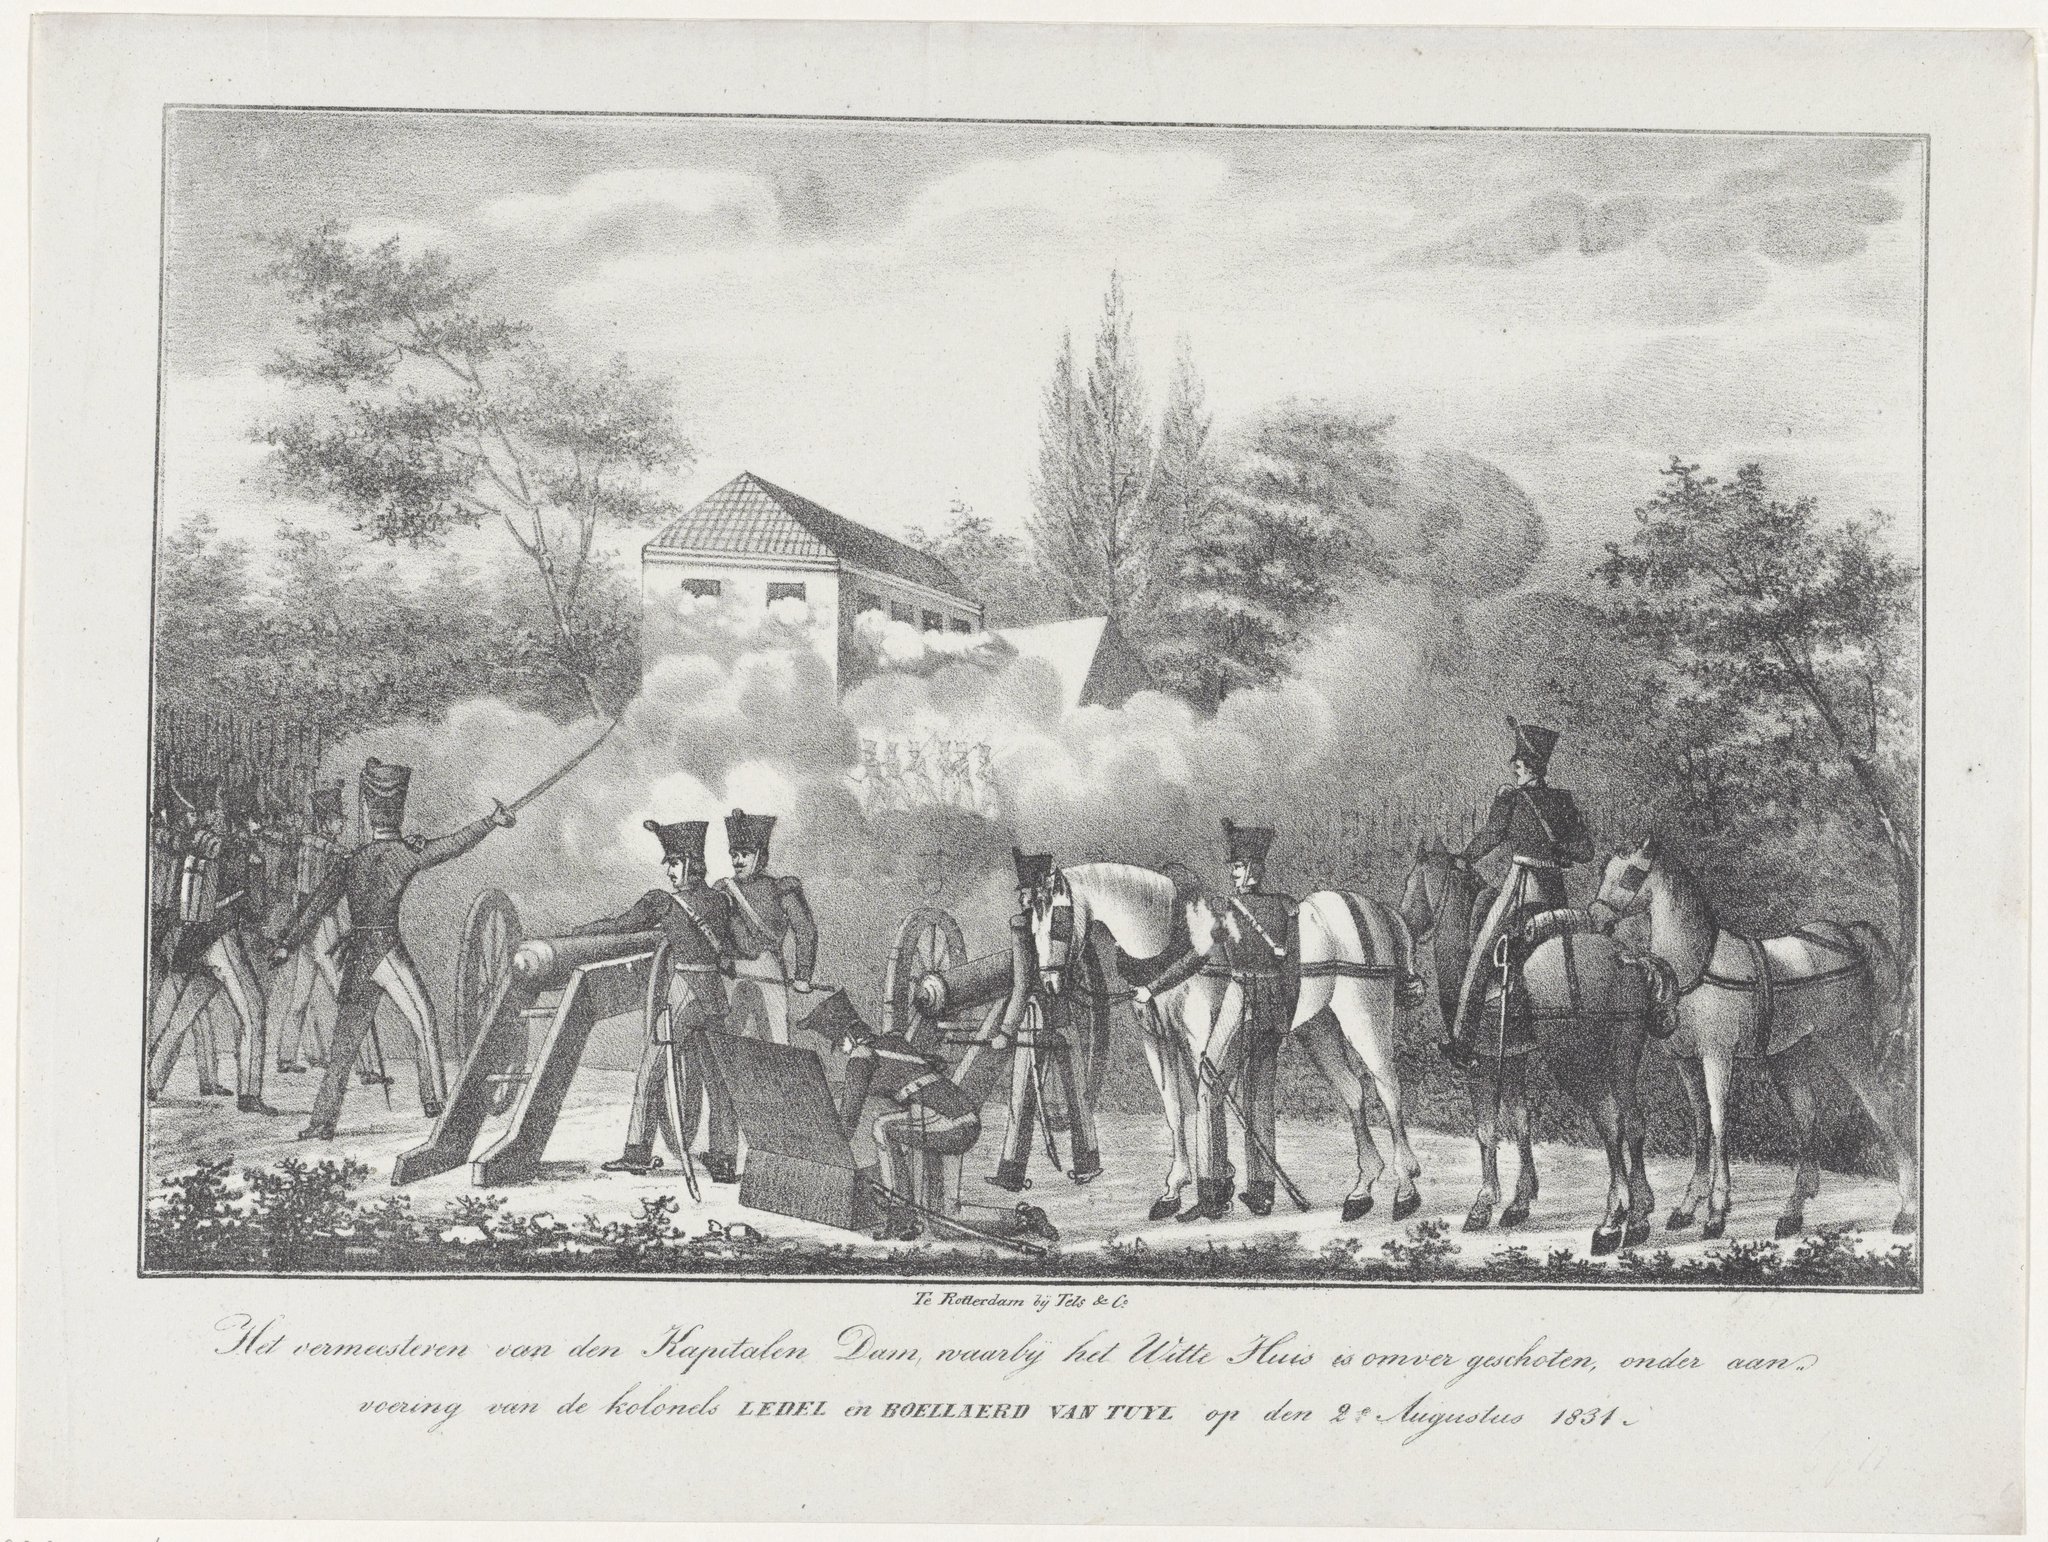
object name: print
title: Verovering van de Kapitalen Dam, 1831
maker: Anonymous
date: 1831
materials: paper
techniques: lithograph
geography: netherlands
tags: small groups in single combat in place of battle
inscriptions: collector's mark: Lugt 2228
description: Verovering van de Kapitalen Dam - een dam bij Sluis in Staats-Vlaanderen - en het Witte Huis door Nederlandse troepen, 2 augustus 1831. De Nederlandse troepen onder bevel van kolonel Joseph Ledel en kolonel Boellaerd van Tuyl. Tijdens de Tiendaagse Veldtocht, 2-12 augustus 1831.